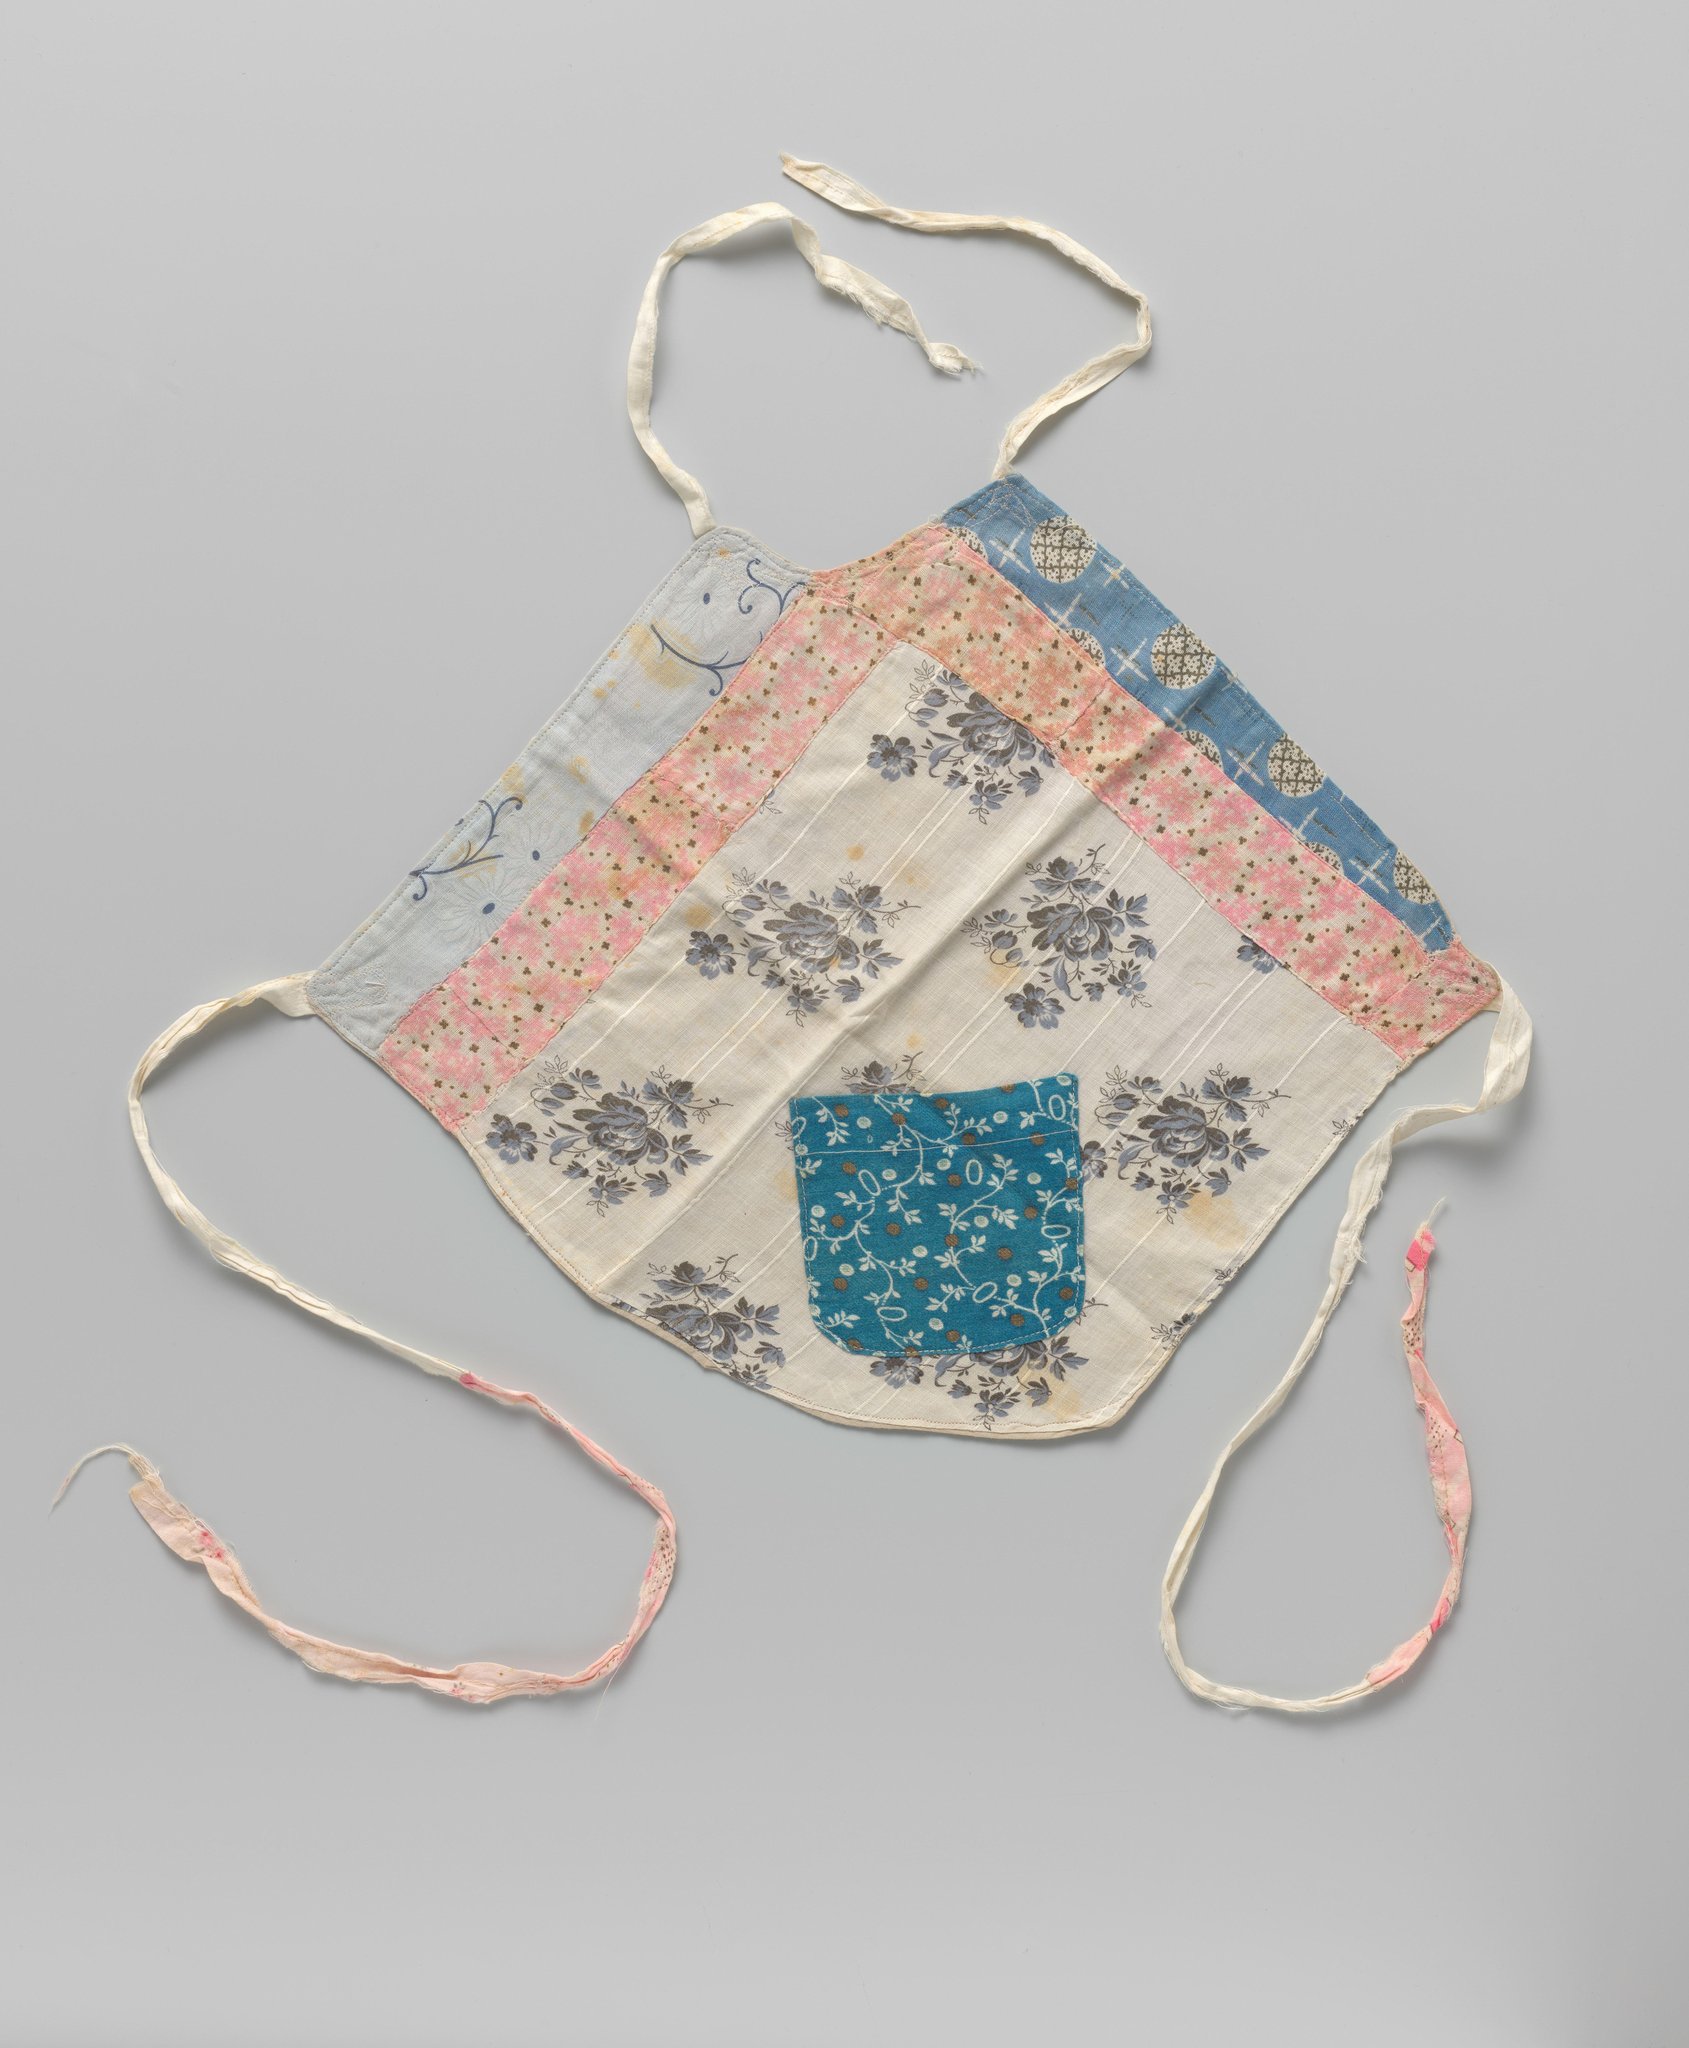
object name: apron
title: Kinderschort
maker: Anonymous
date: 1880-1930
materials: textile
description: Kinderschort samengesteld uit vijf verschillend bedrukte fragmenten textiel. Het schort heeft vier linten en een zak midden op de voorzijde.